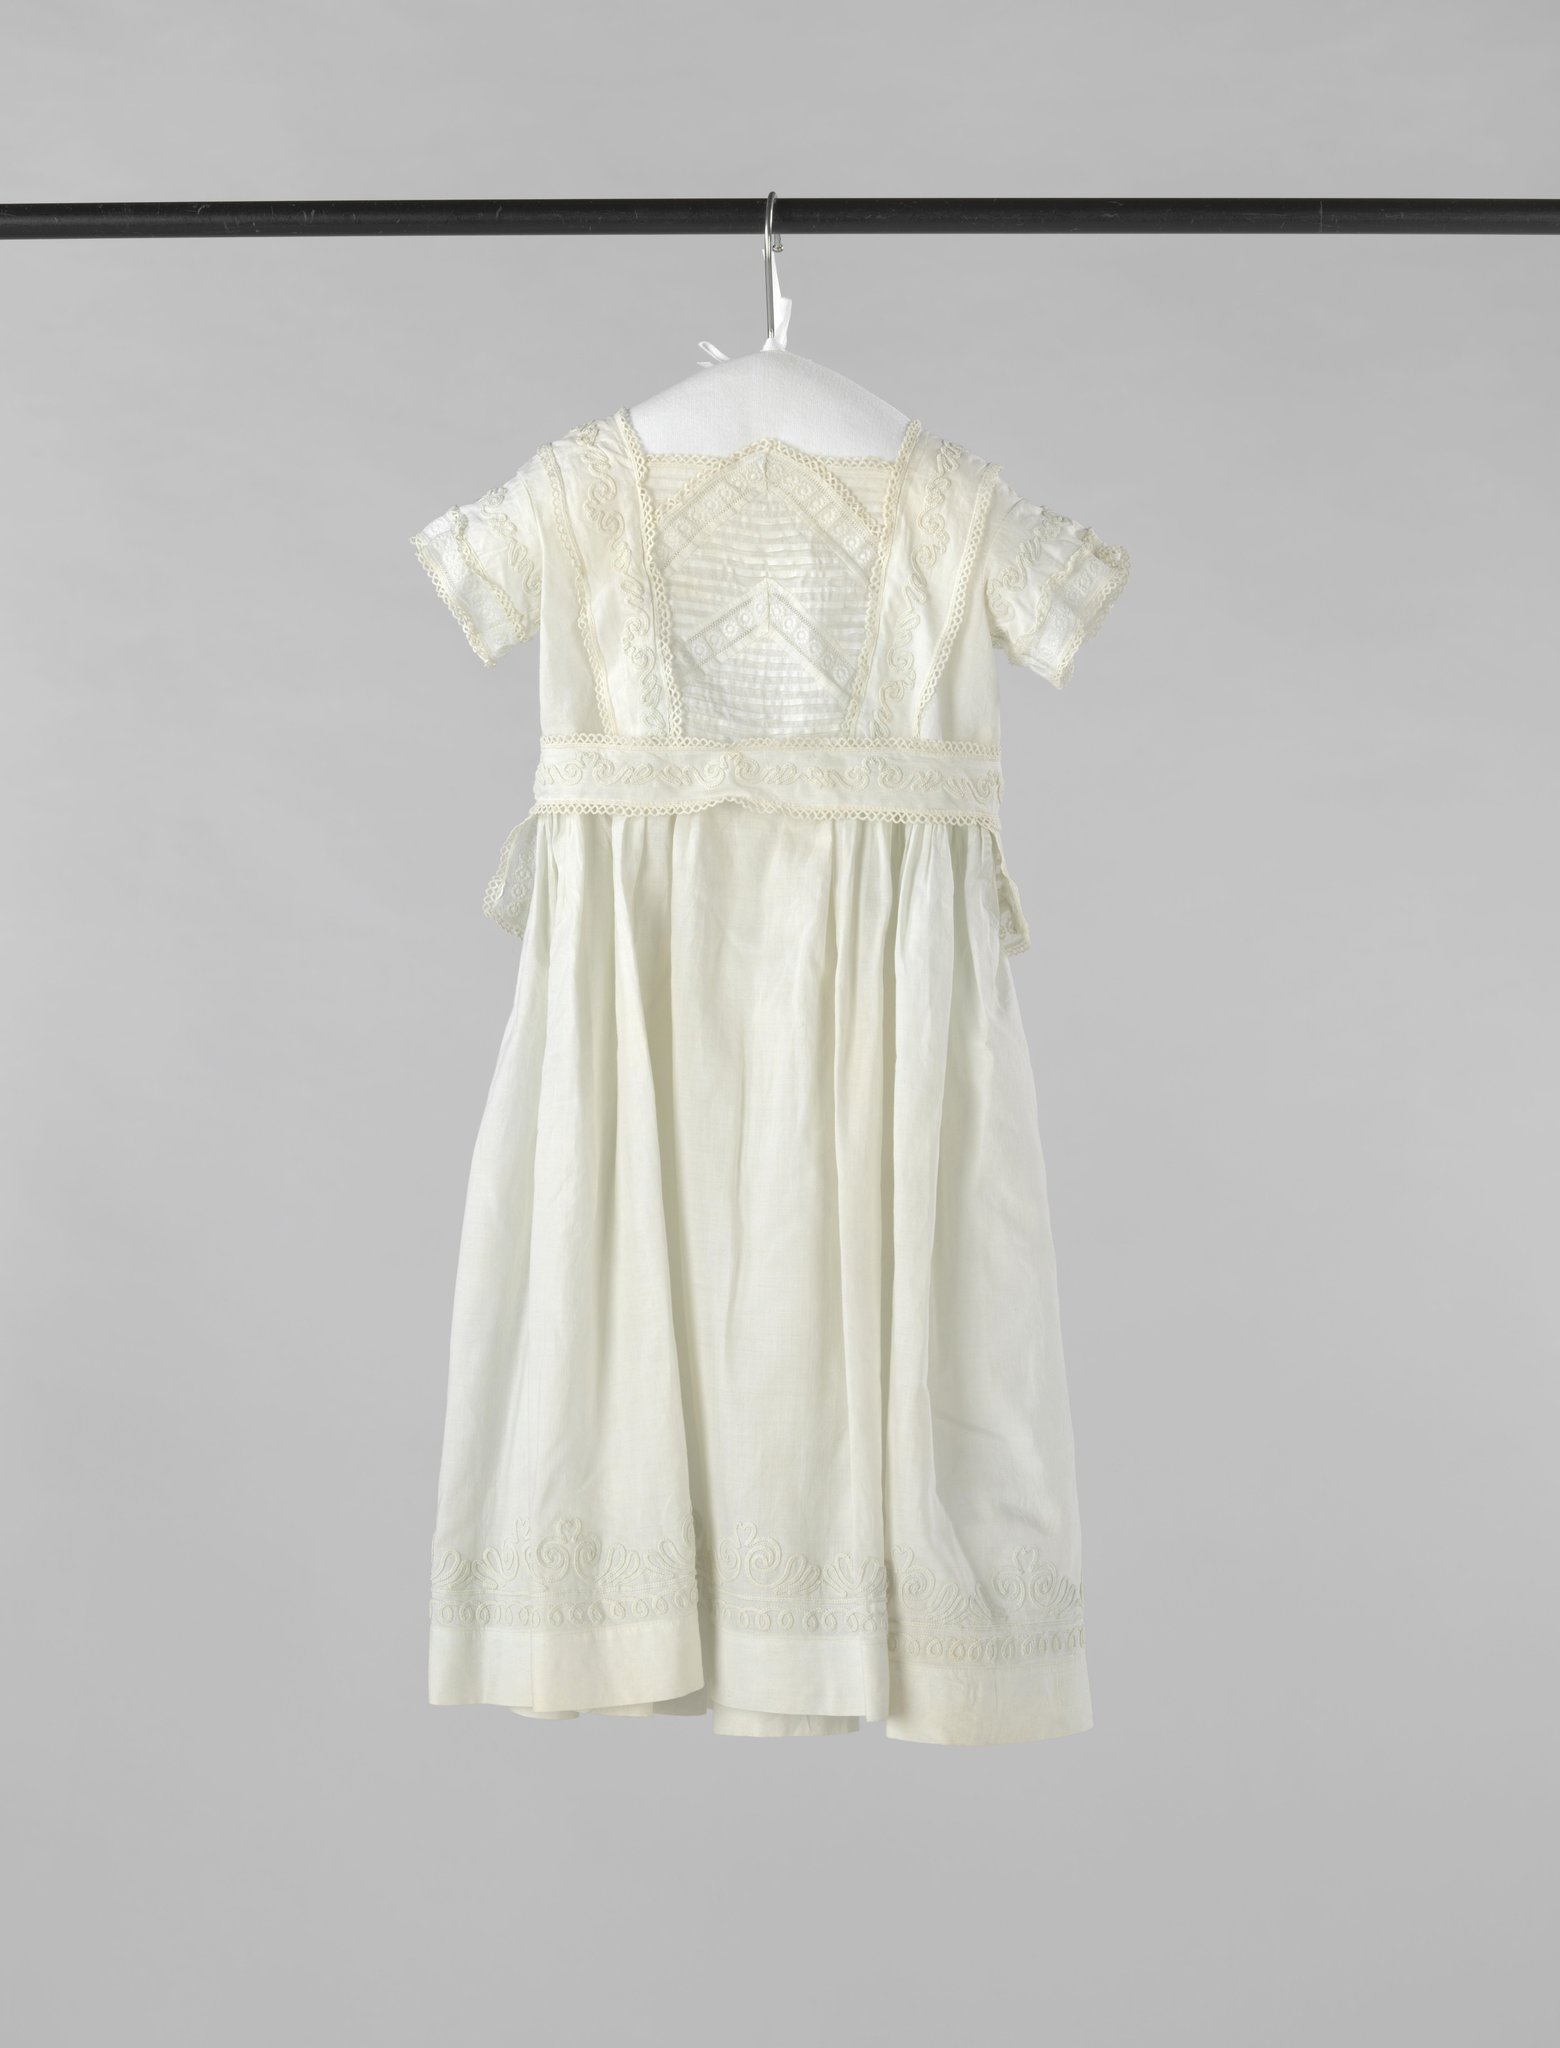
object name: childrenswear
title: Kinderjurk van wit linnen met soutache en tussenzetsels, met ceintuur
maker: Anonymous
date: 1880-1890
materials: linen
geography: netherlands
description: Een kinderjurk met ceintuur, van wit linnen met soutache en tussenzetsels.